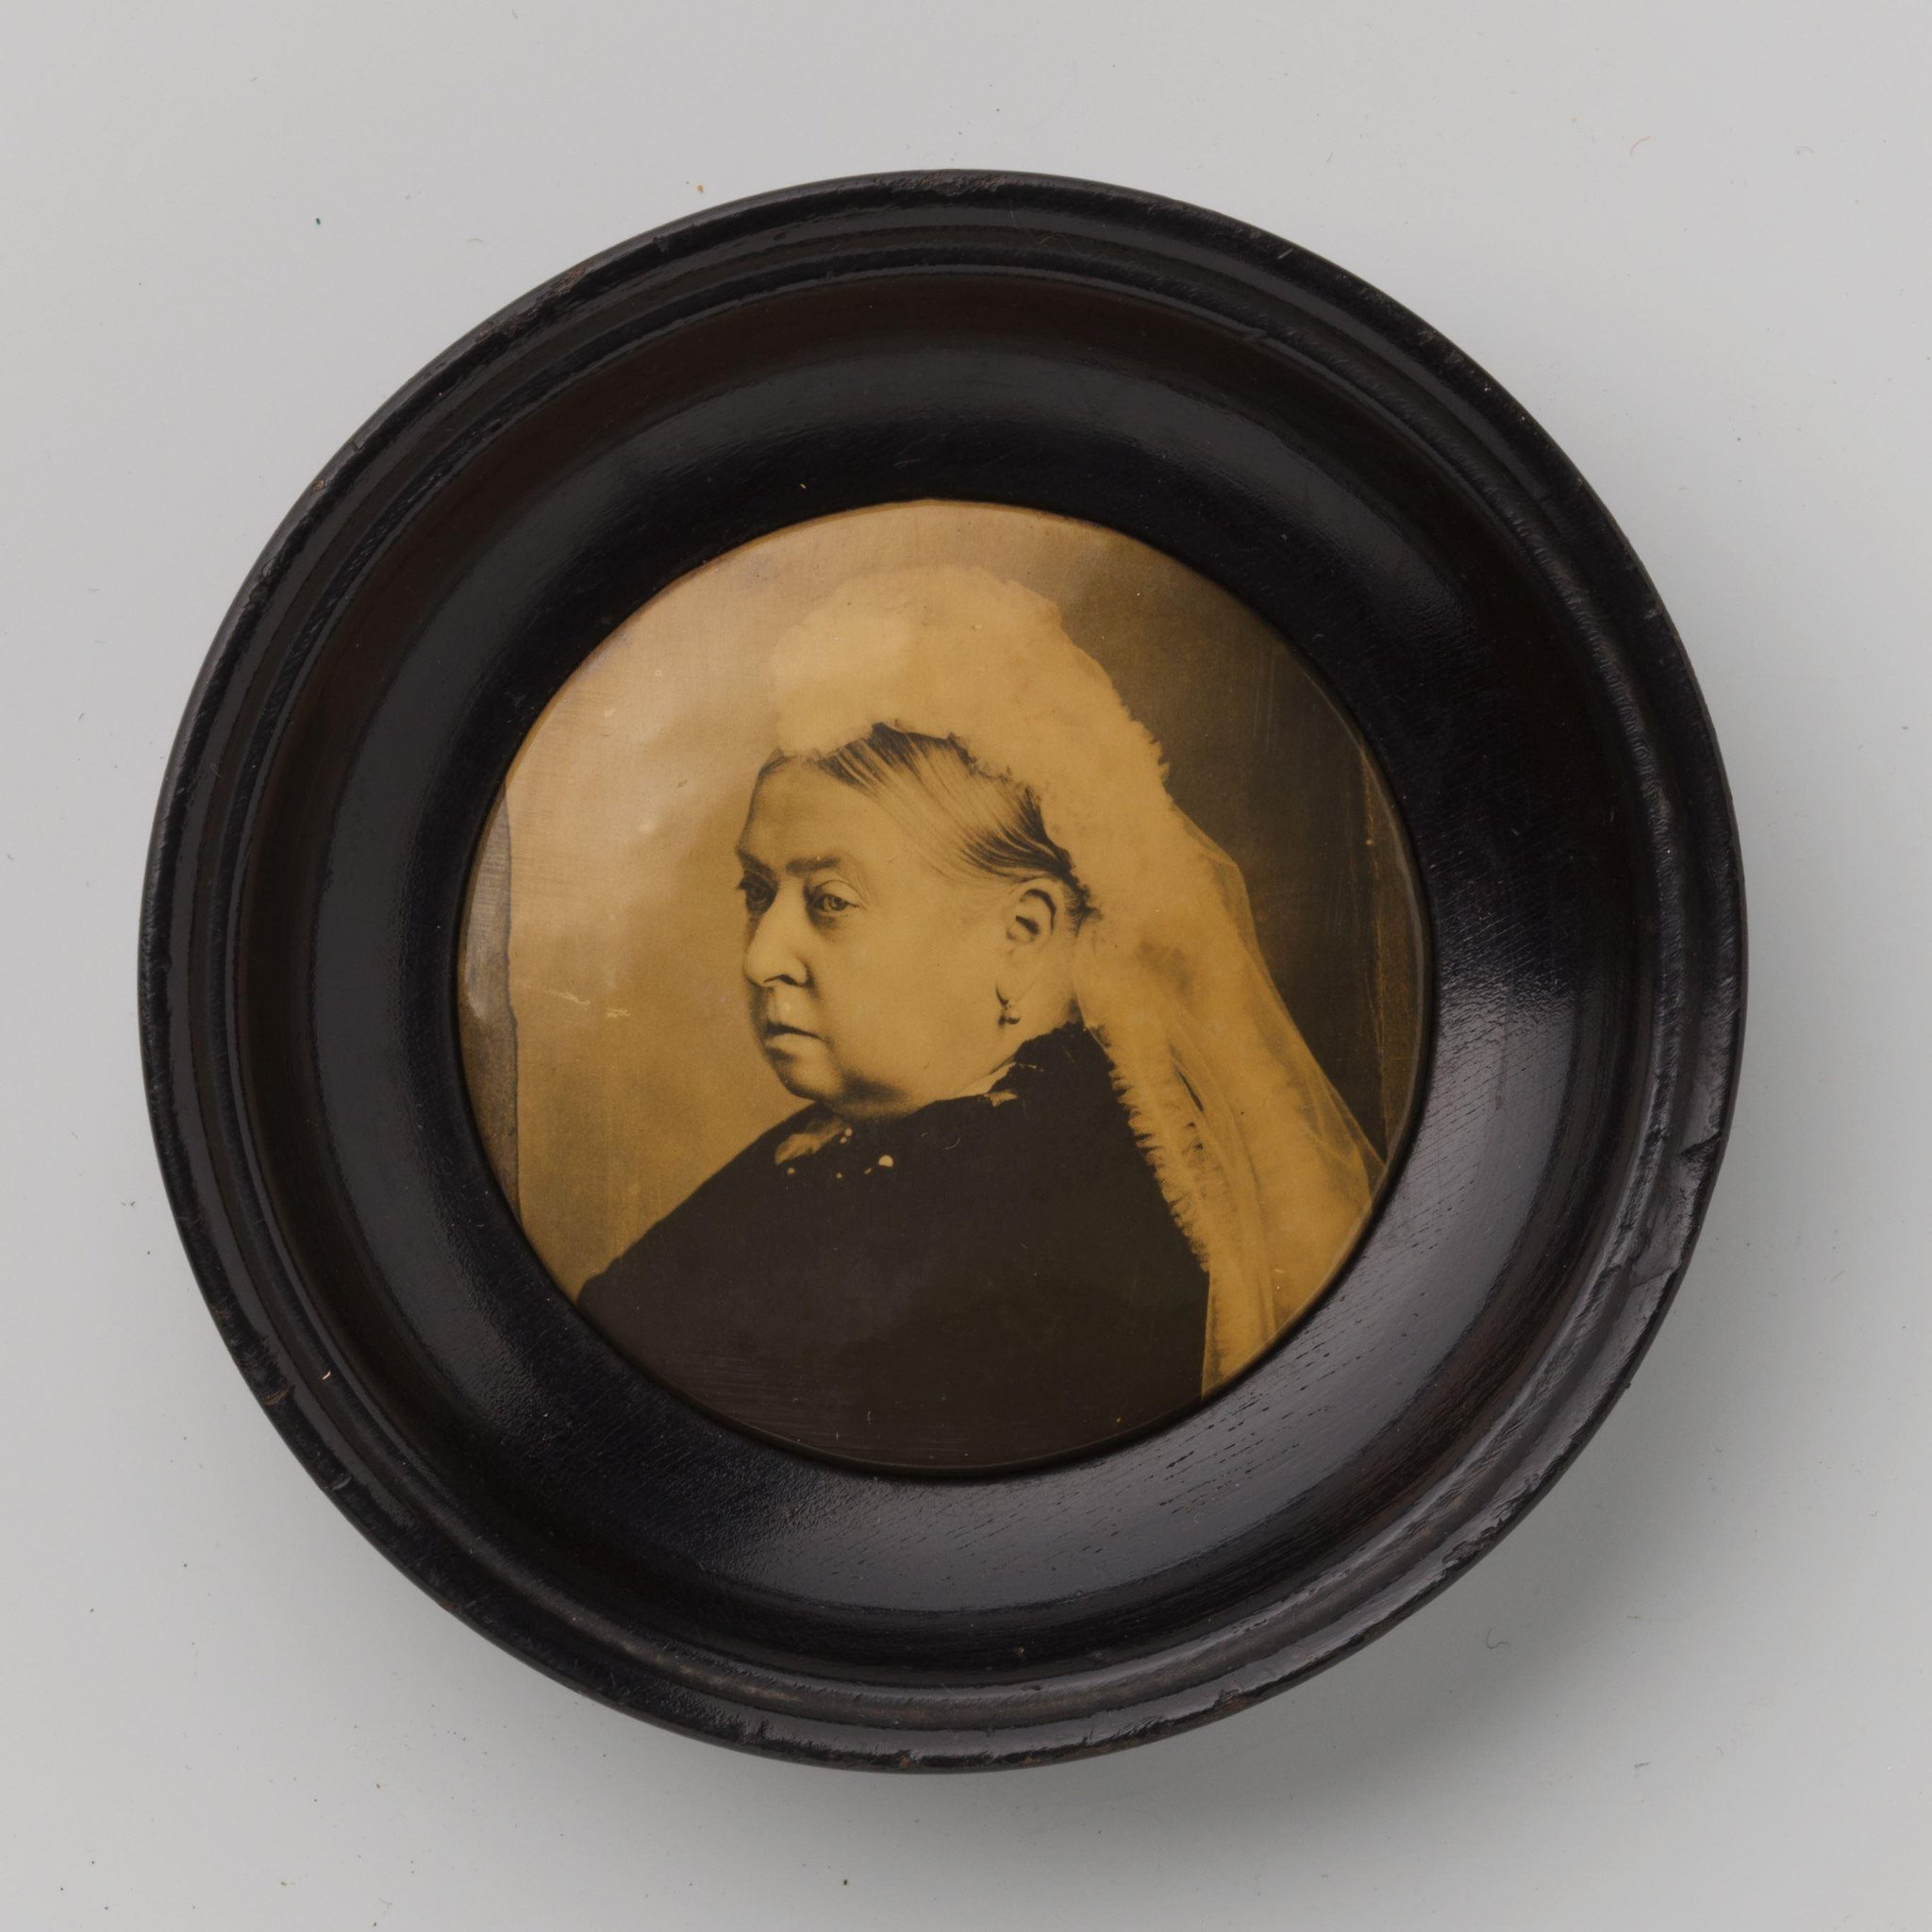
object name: frame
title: Portret van koningin Victoria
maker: Anonymous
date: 1880-1900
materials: cardboard, metal, wood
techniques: photobutton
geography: great britain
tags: victoria (koningin van het verenigd koninkrijk en keizerin van india), historical persons, queen, great britain